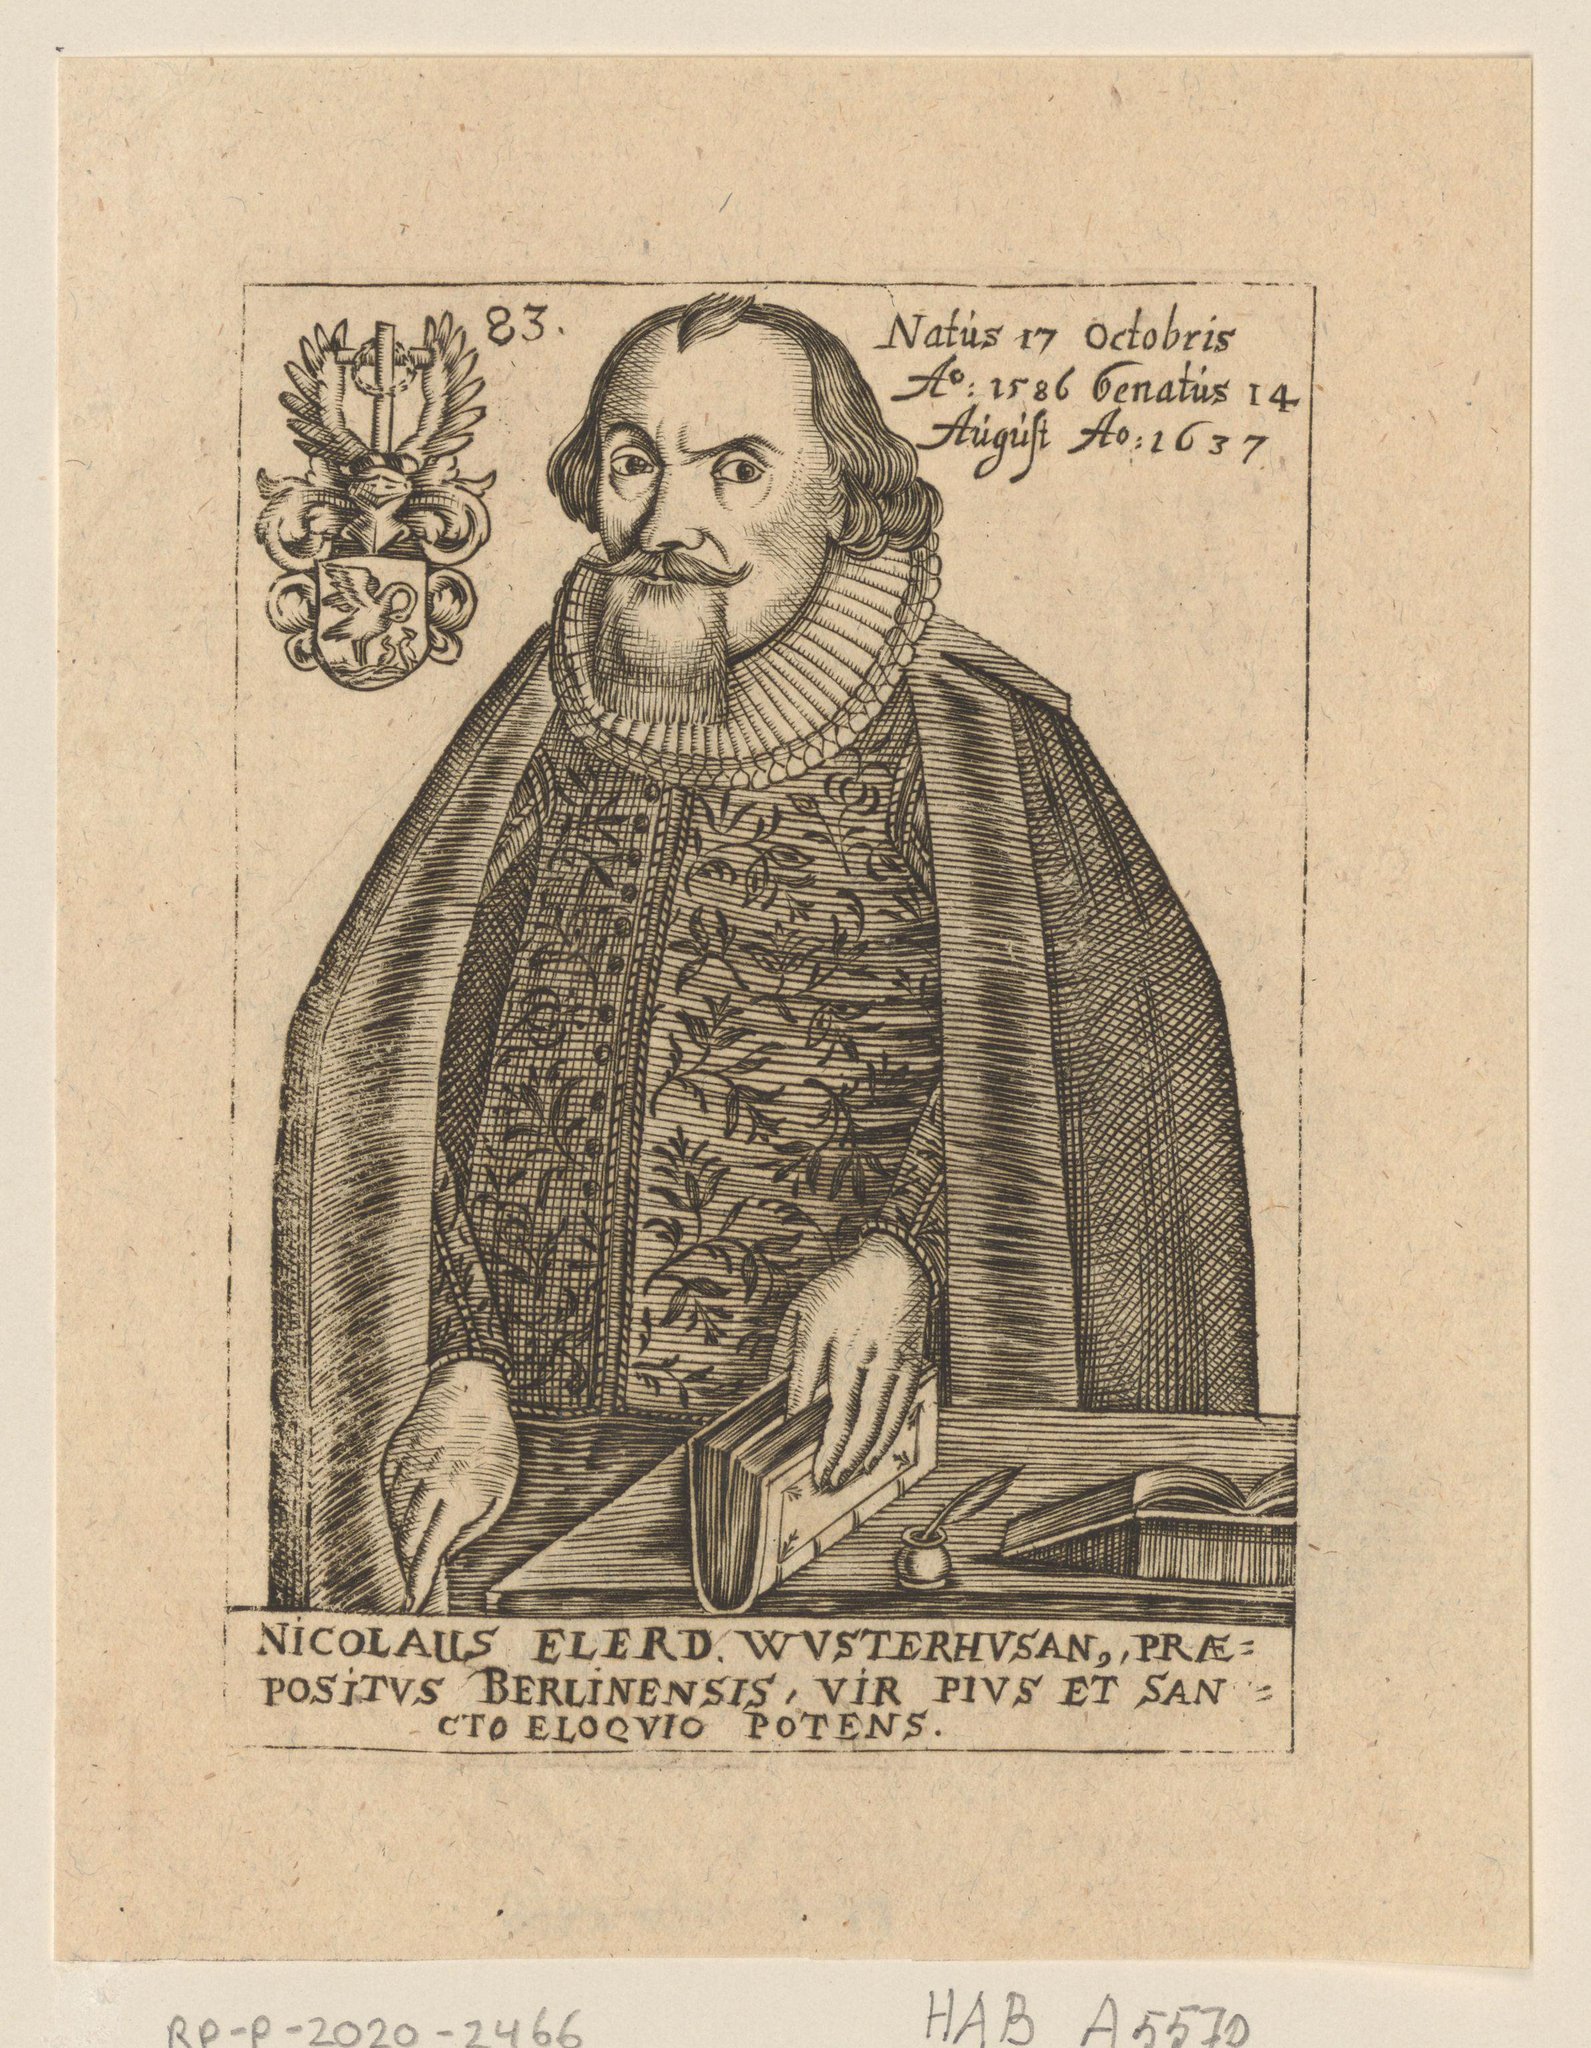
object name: print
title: Portret van Nicolaus Elerdt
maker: Anonymous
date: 1751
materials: paper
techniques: engraving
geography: germany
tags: berlin, theologian, historical persons, book, armorial bearing, heraldry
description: Prent waarschijnlijk uit: Küster, Georg Gottfried en Martin Friedrich Seidel. Martin Friedrich Seidels Bilder-Sammlung (...). Berlijn: Verlag des Buchladens bey der Real-Schule, 1751.